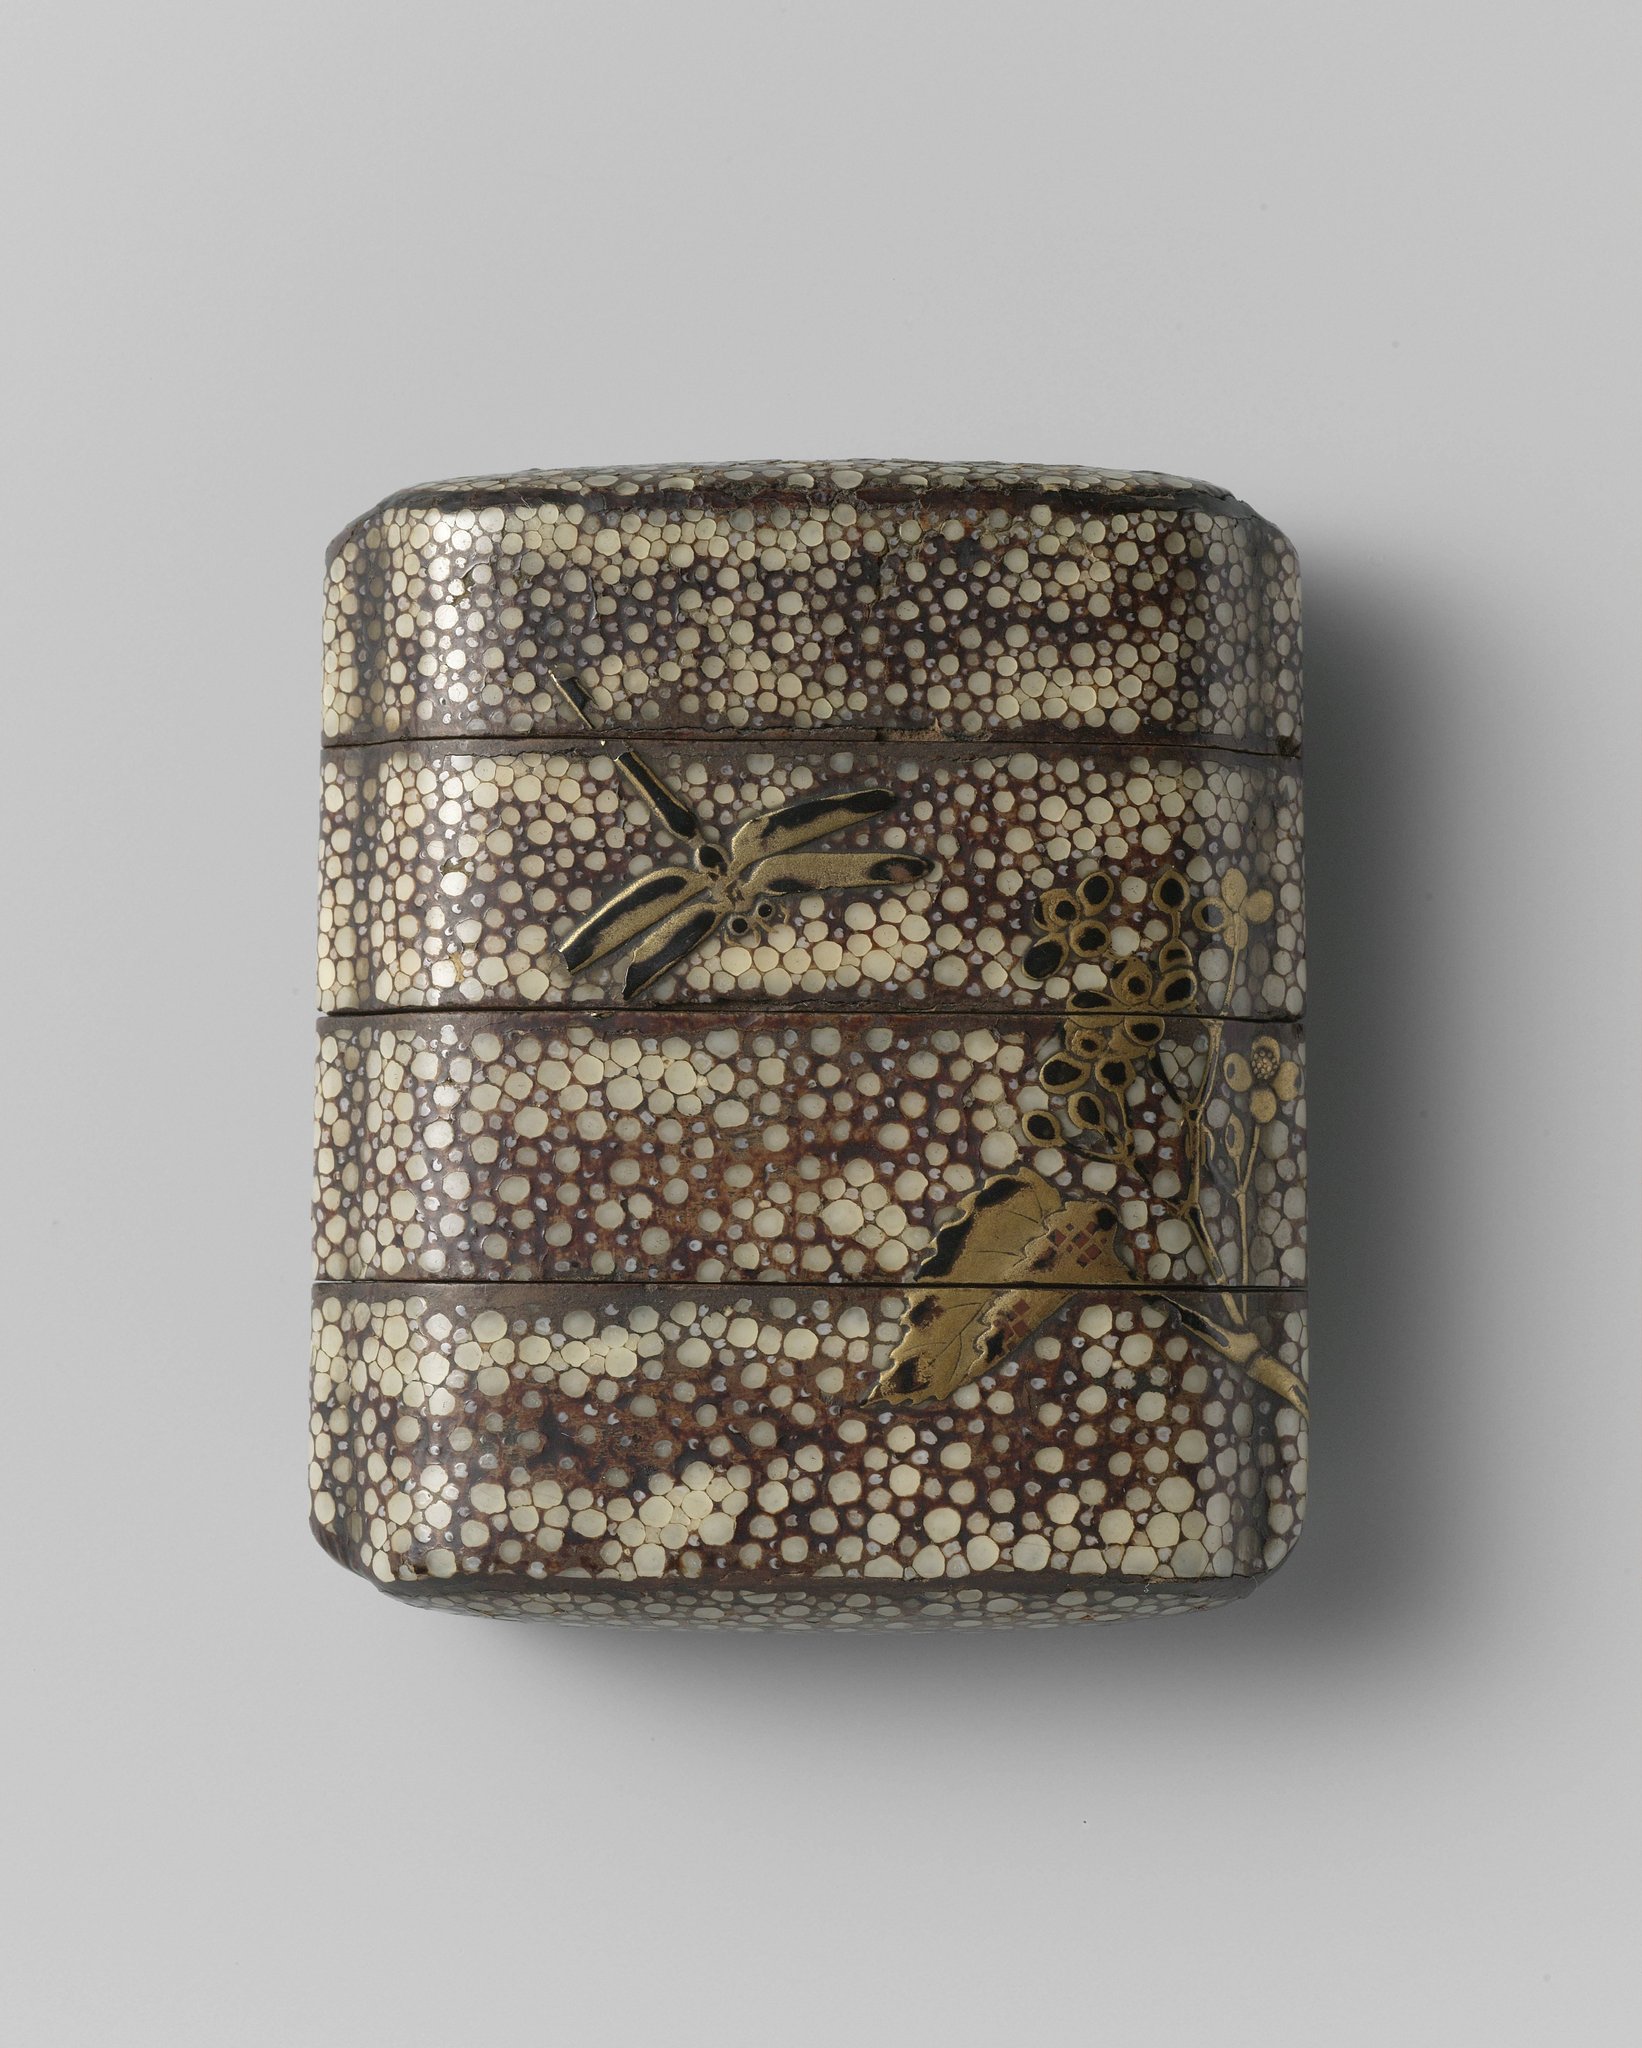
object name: medicijndoos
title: Inro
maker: Anonymous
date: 1600-1850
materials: lacquer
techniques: gilding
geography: japan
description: Inro in vier delen. Lakwerk, versierd in goud makie met een libelle bij een bloeiende hortensiatak.